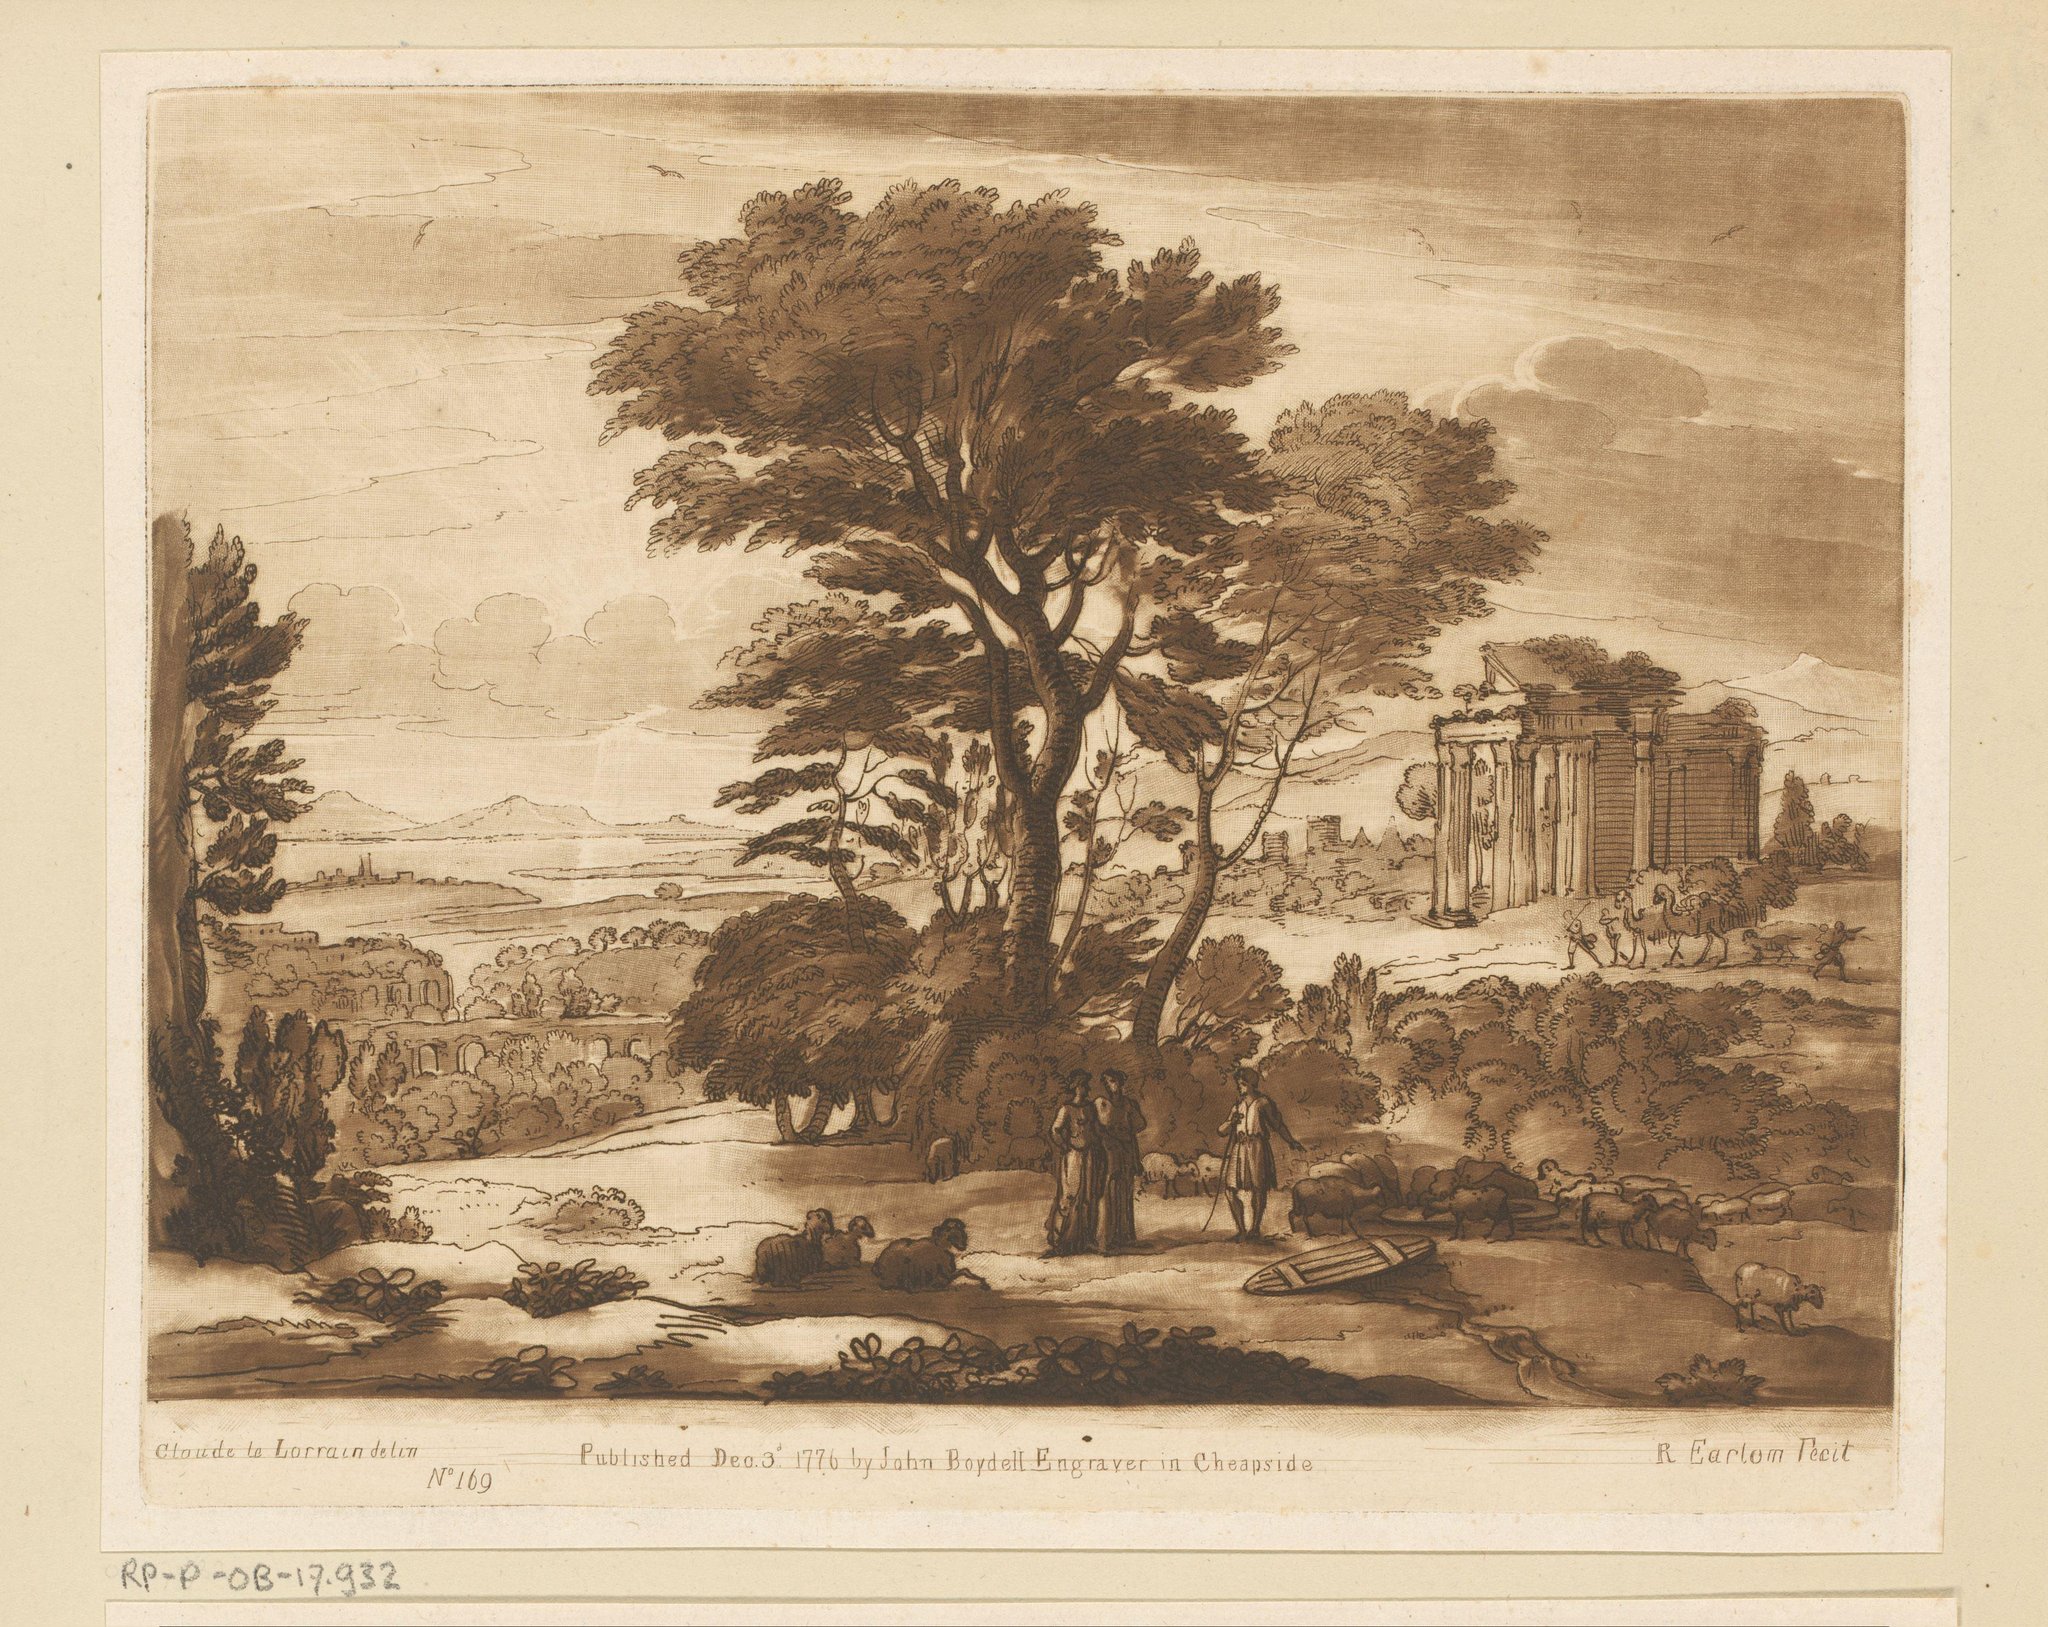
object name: print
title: Prenten naar tekeningen van Claude Lorrain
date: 1776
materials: paper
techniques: etching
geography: london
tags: river - hh - ideal landscapes, landscape with ruins - ii - ideal landscapes, jacob moves the stone which covers the opening of the well and waters rachel's sheep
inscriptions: date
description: Vanaf 1774 publiceerde John Boydell tweehonderd prenten naar het tekeningenboek Liber Veritatis van Claude Lorrain, in het bezit van de hertogen van Cavendish. Deze prenten werden vanaf 1777 in twee volumes gebundeld uitgegeven.